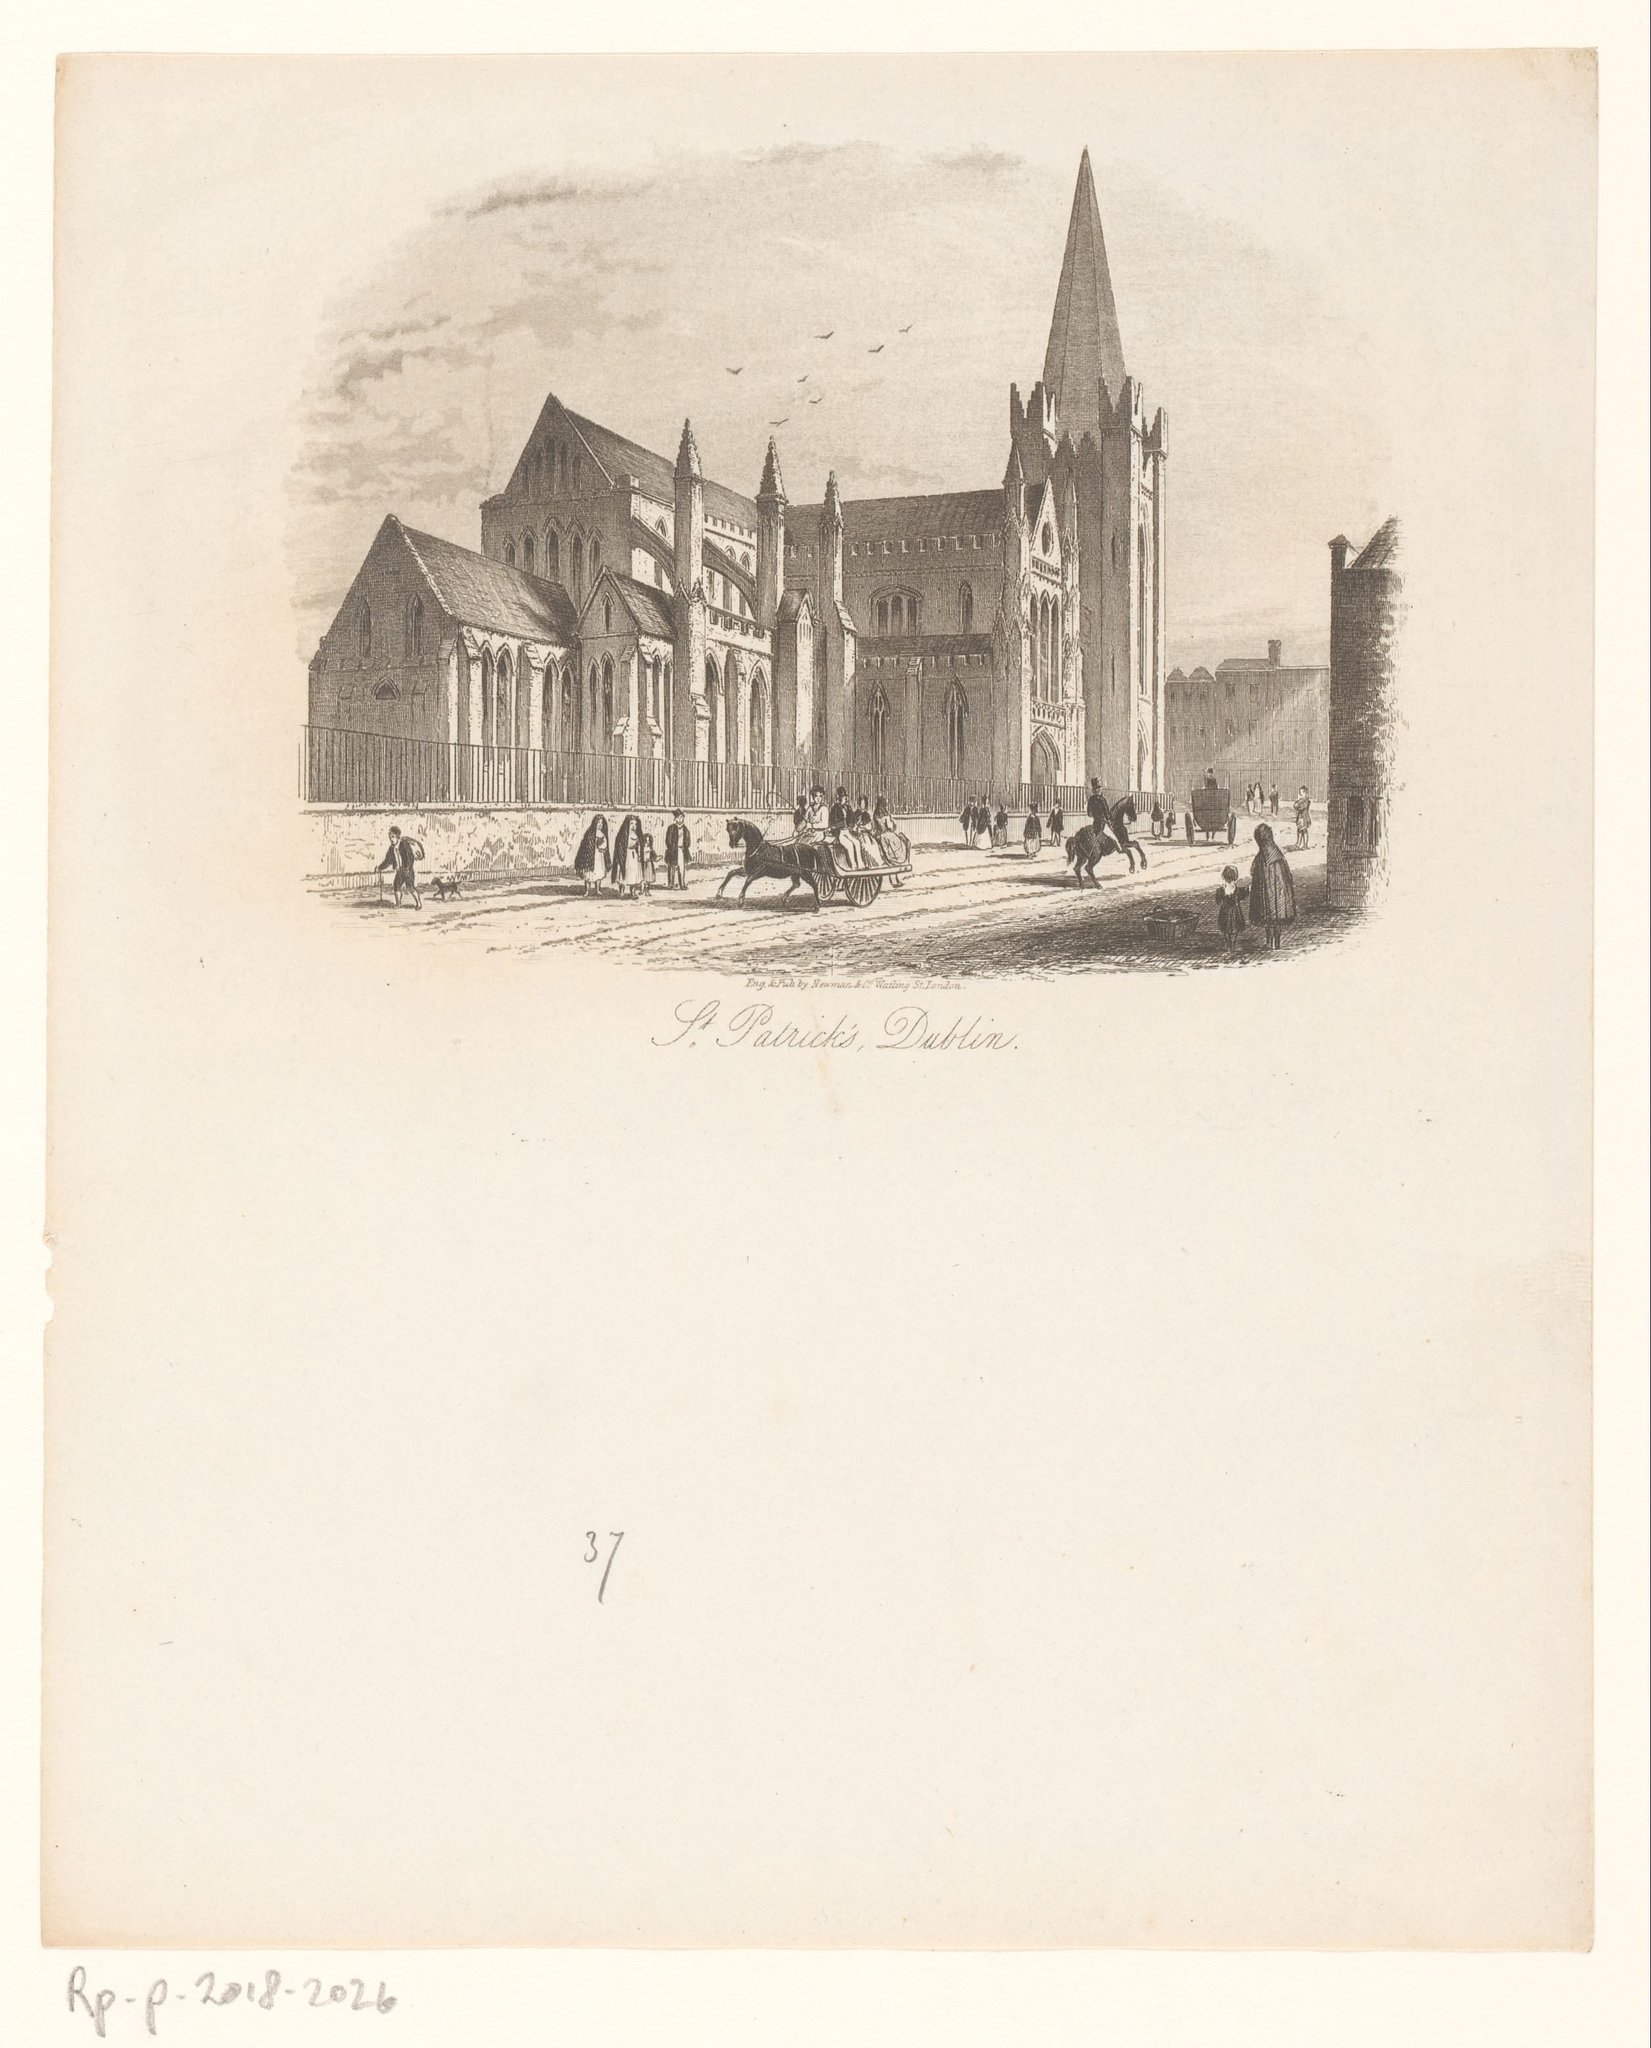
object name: print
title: Gezicht op Saint Patrick's Cathedral, te Dublin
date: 1848-1874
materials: paper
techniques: etching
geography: london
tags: church (exterior)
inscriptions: collector's mark: Lugt 2228